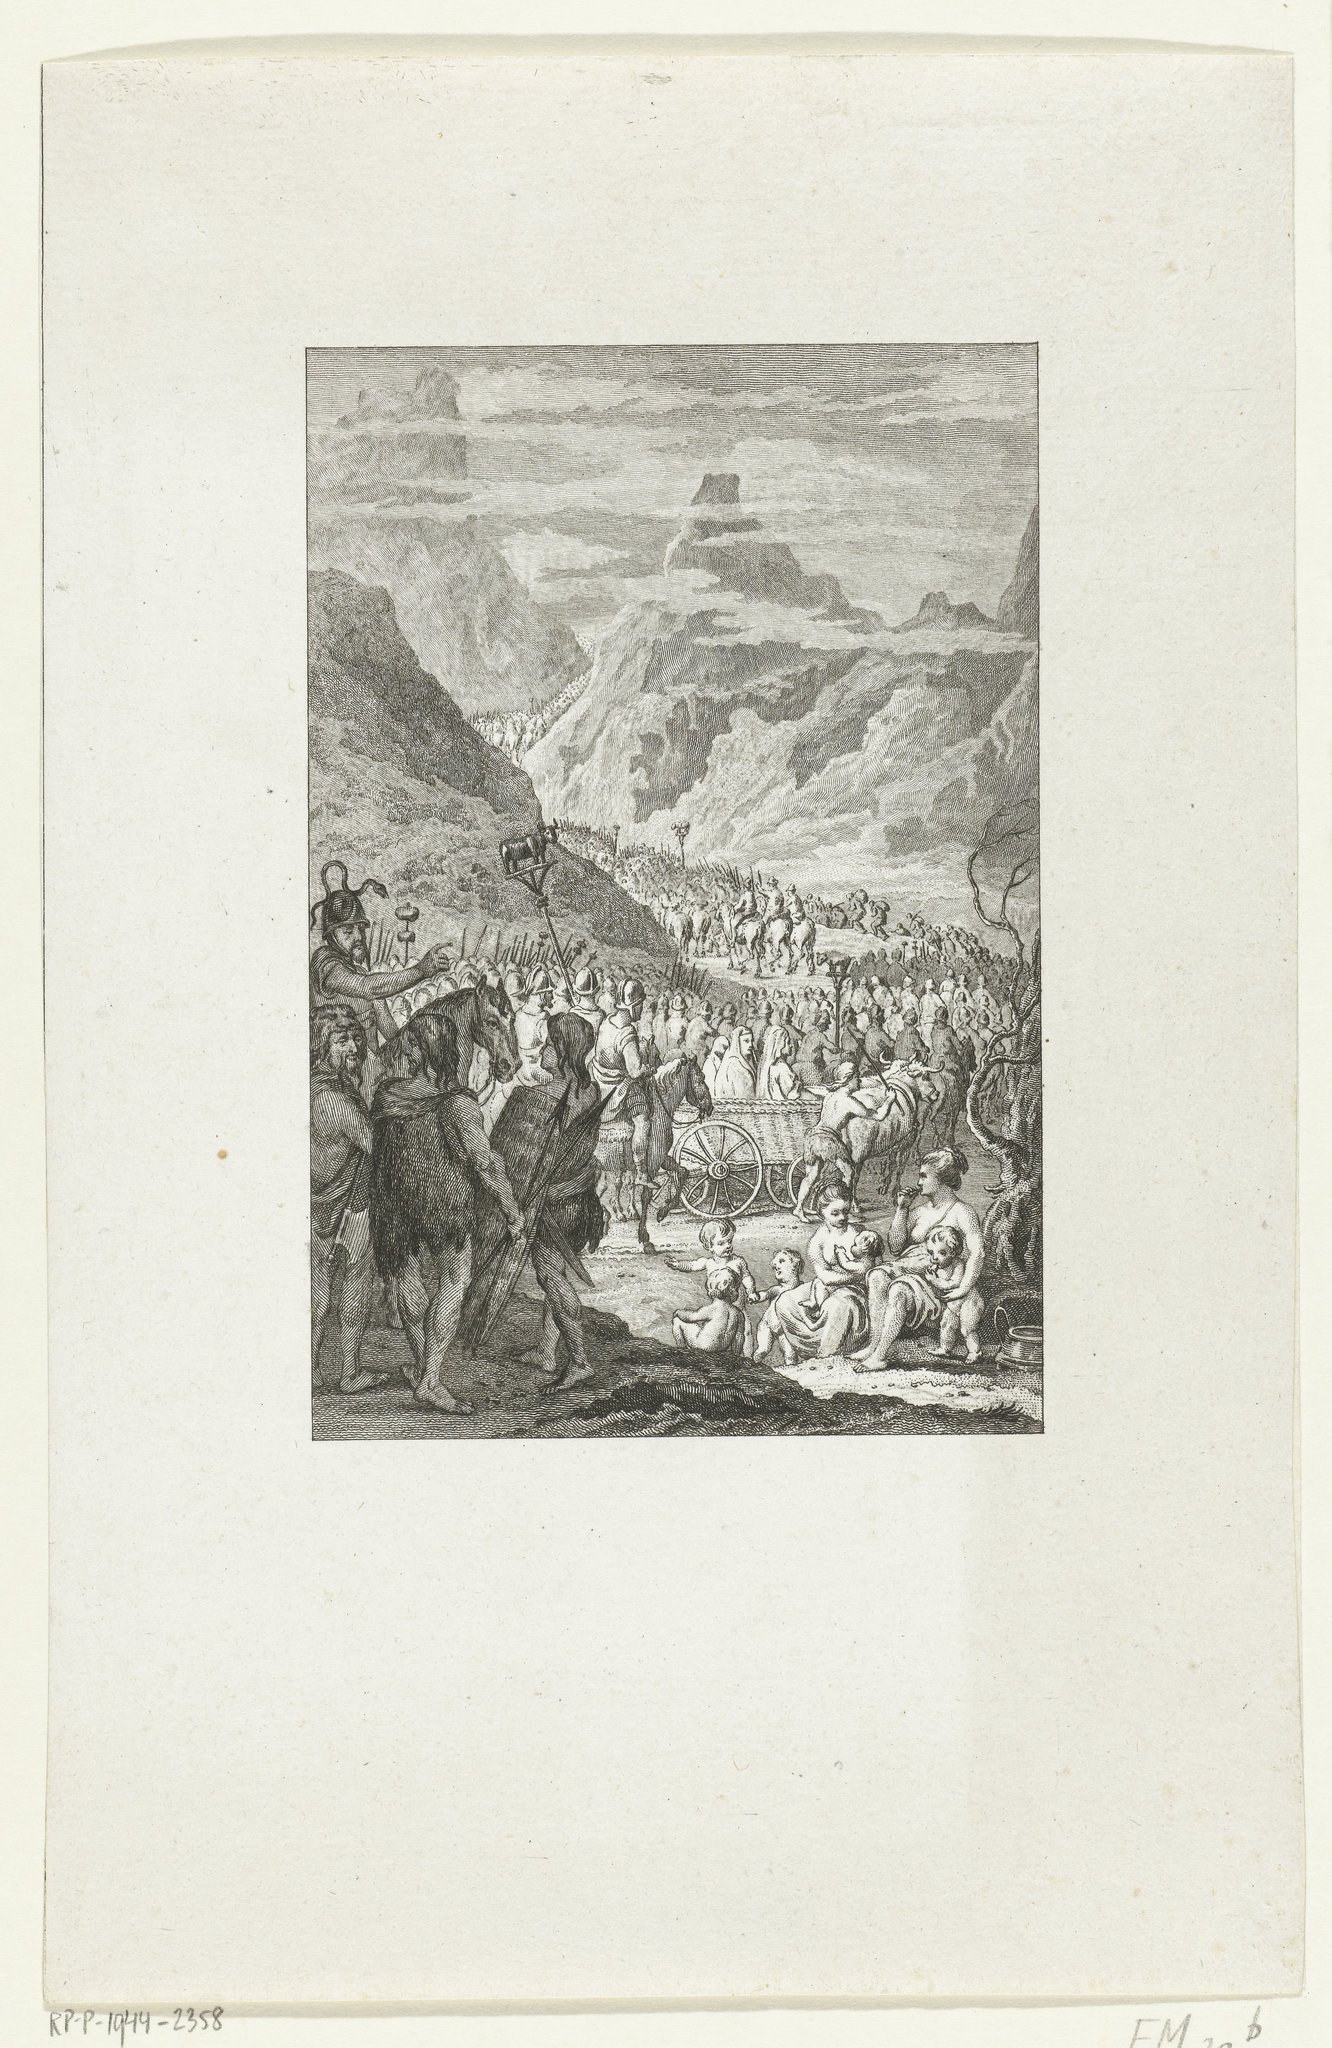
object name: history print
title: De Cimbren trekken over de Alpen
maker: reinier vinkeles (i)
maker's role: draughtsman, print maker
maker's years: 1741-1816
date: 1782-1784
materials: paper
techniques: etching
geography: netherlands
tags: extinct, 'historical' peoples (with name)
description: Illustratie voor: E.M. Engelberts, De aloude staat en geschiedenissen der Vereenigde Nederlanden, Johannes Allart, Amsterdam 1784-1799, deel I, p. 234. Druk vóór de letter.